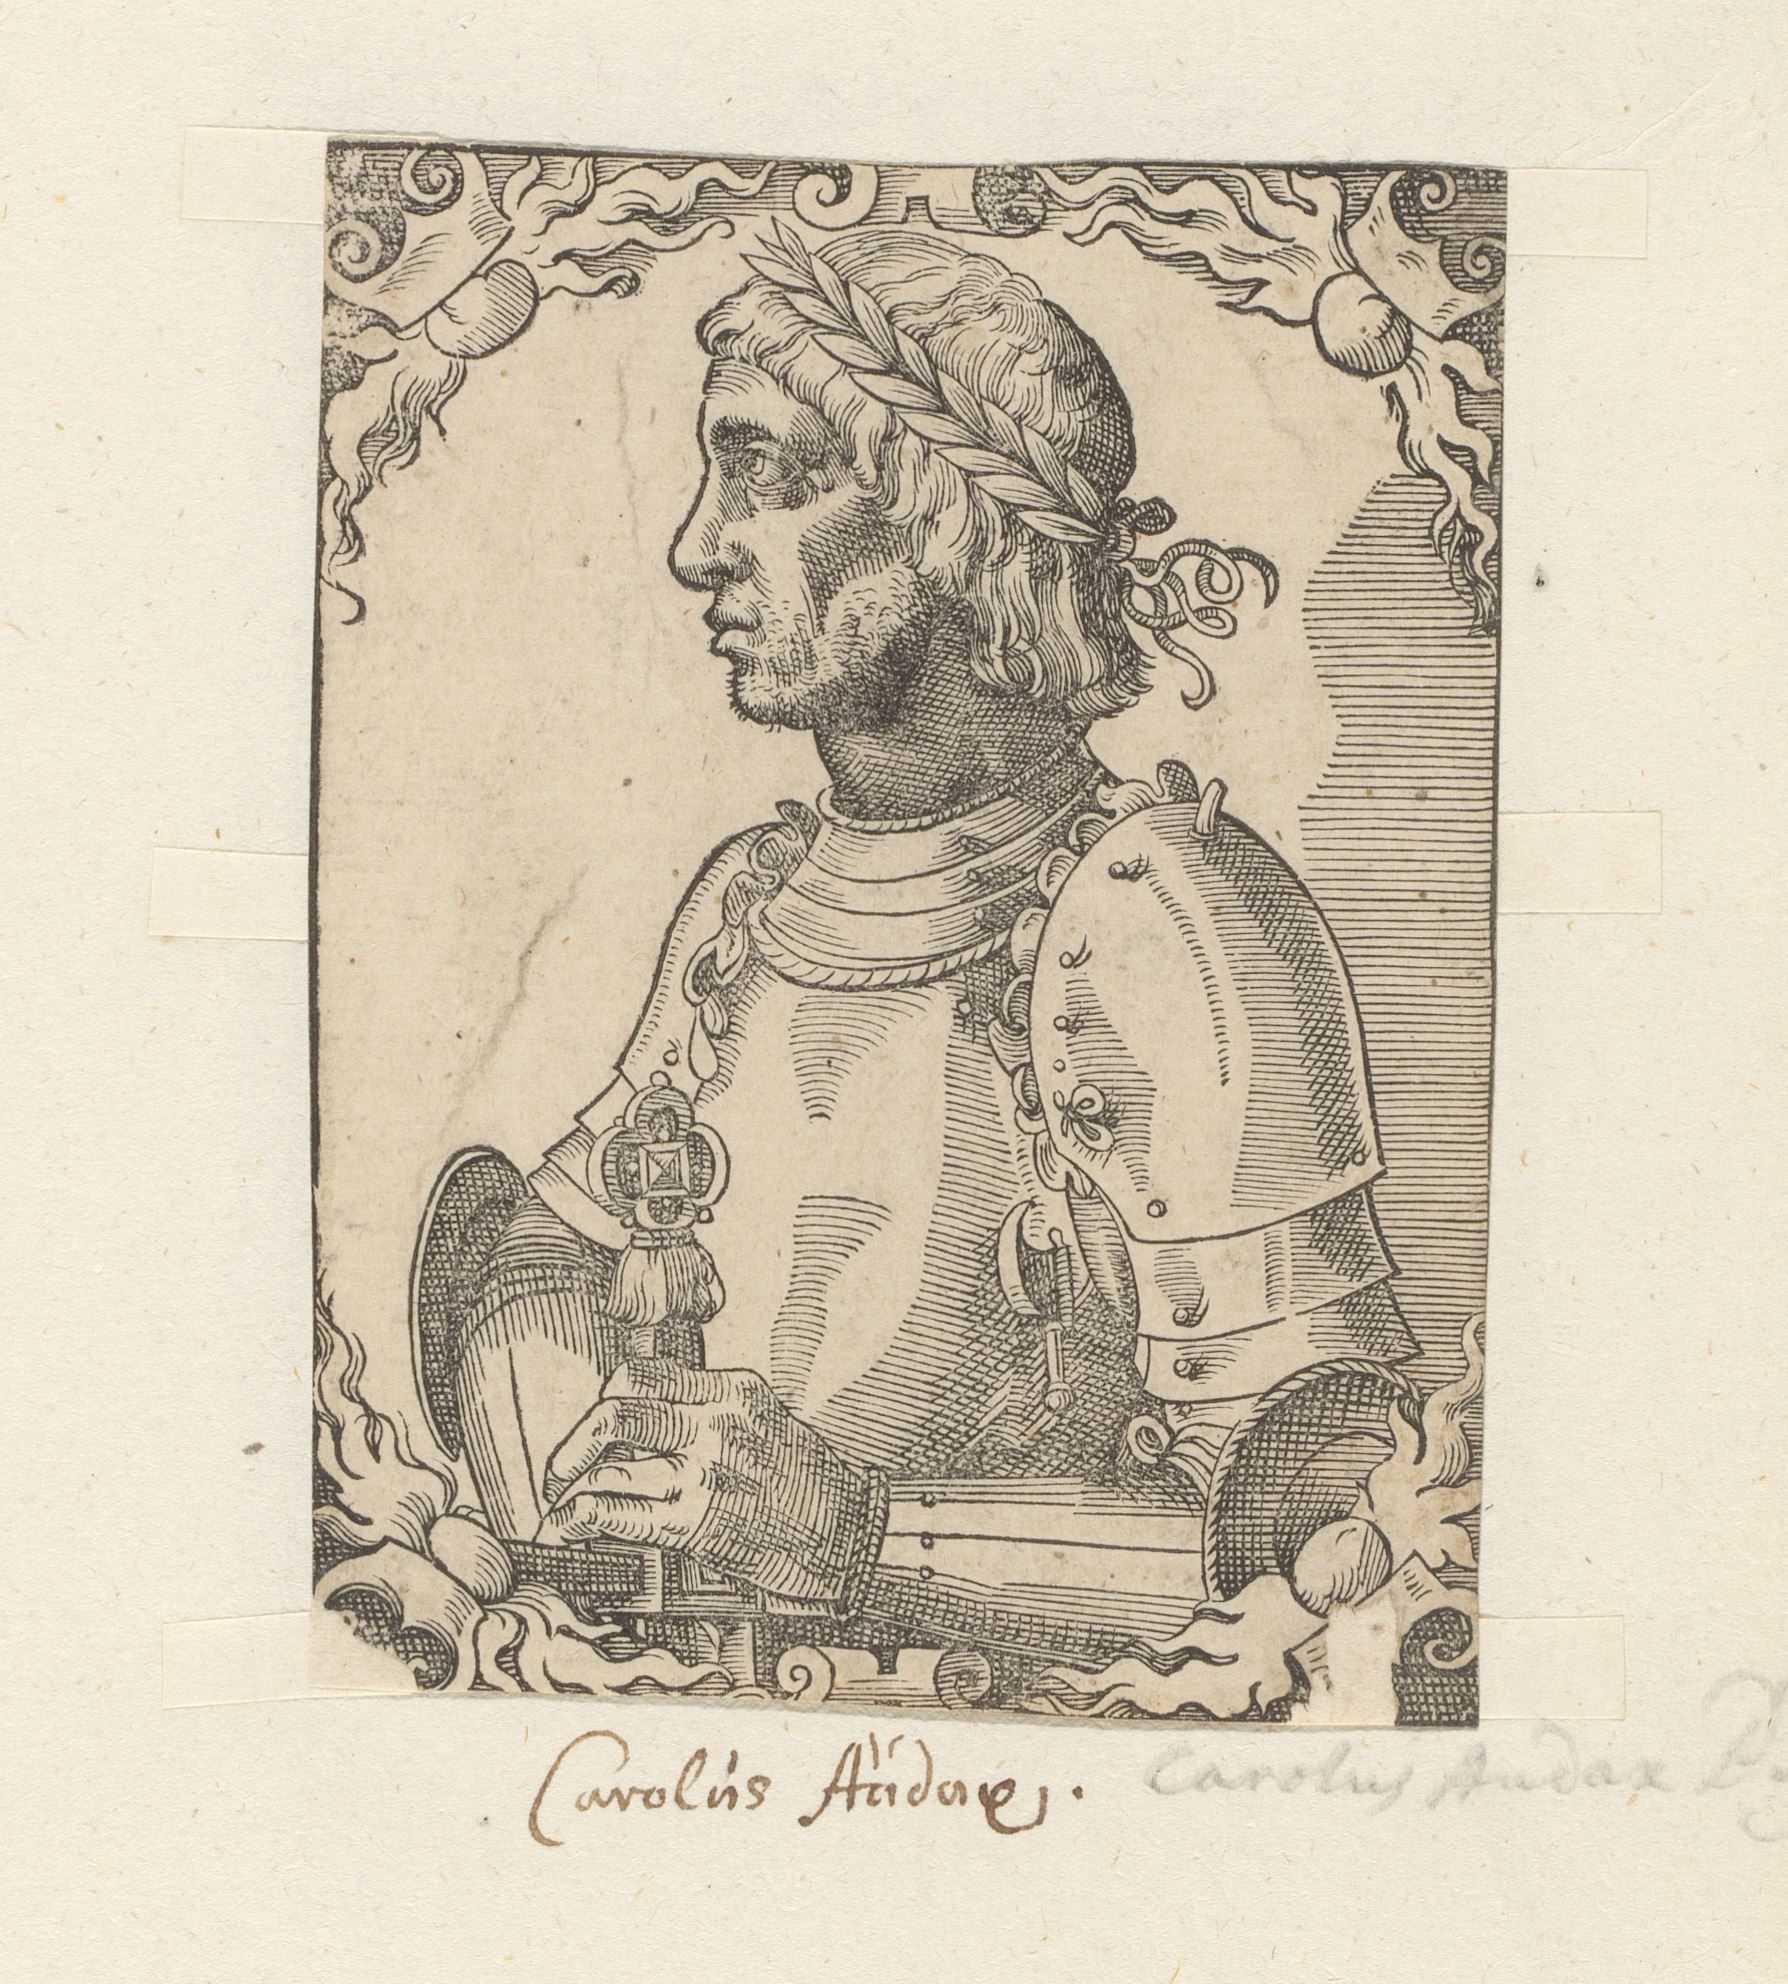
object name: album leaf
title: Portret van Karel de Stoute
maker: Anonymous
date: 1549-1575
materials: paper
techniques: woodcut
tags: earl, charles the bold (duke of burgundy), historical persons, ruler, sovereign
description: Prent gebruikt in: Giovio, Paolo. Elogia Virorum bellica virtute illustrium (...). Bazel: Peter Perna, 1575.